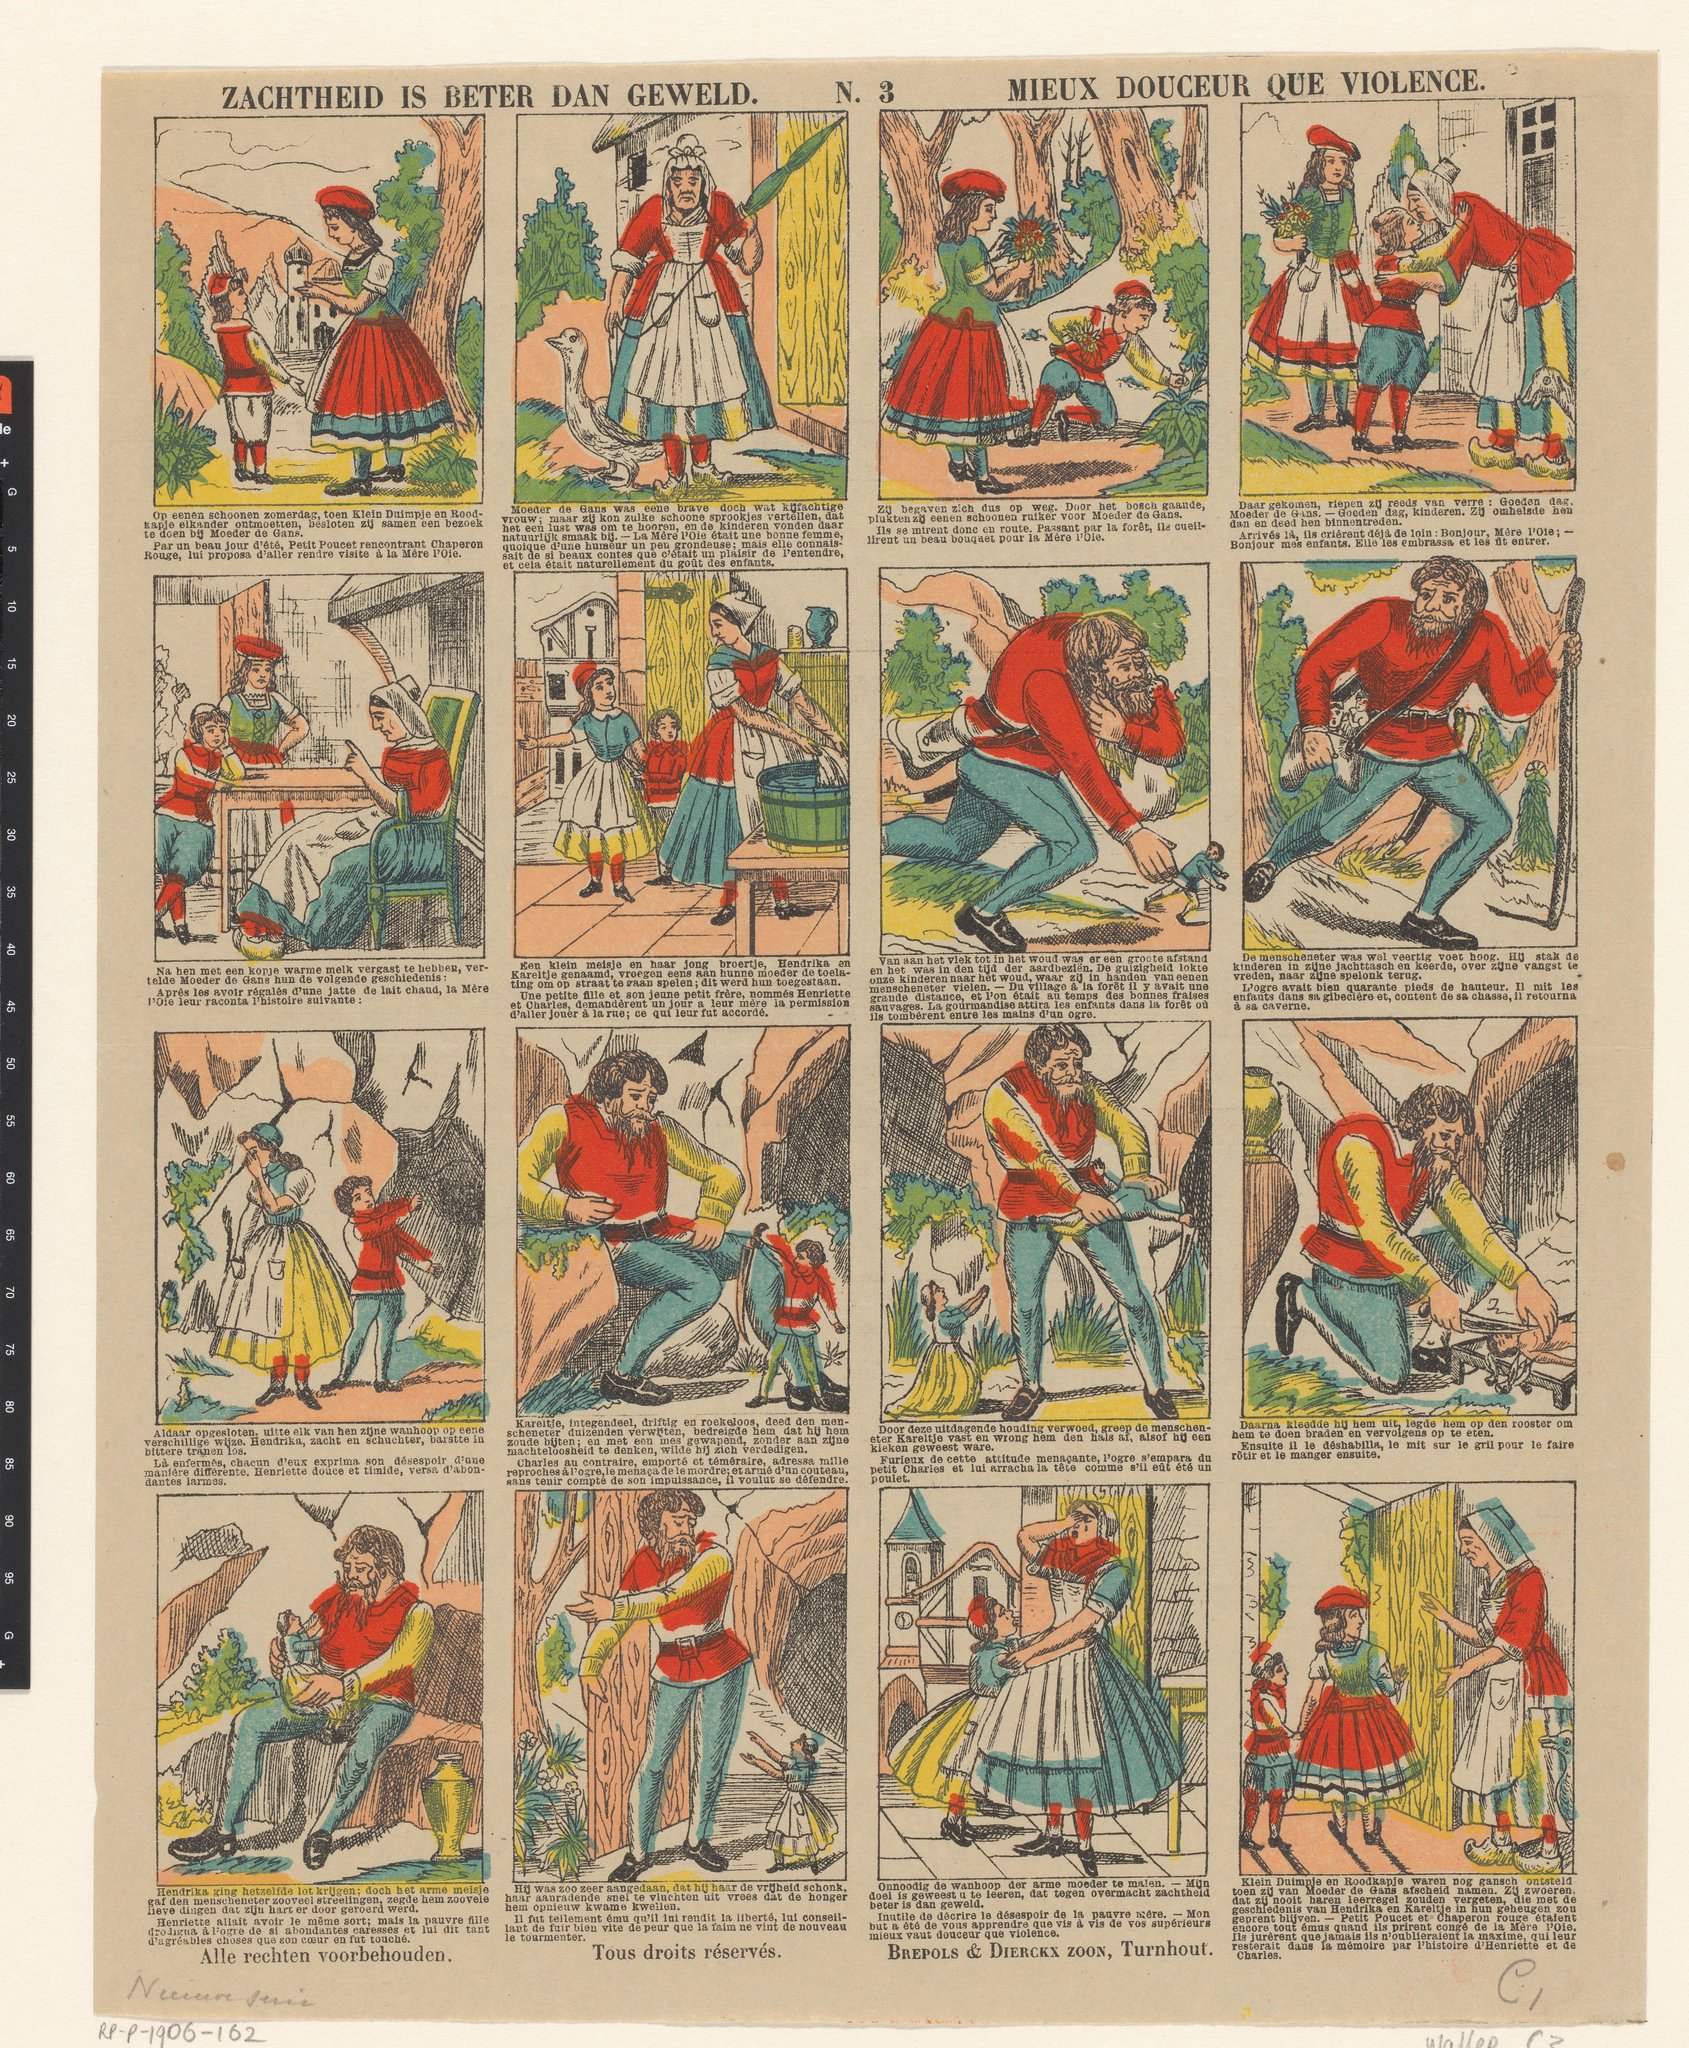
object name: popular print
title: Zachtheid is beter dan geweld / Mieux douceur que violence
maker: Anonymous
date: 1833-1906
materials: paper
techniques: lithograph, letterpress printing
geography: turnhout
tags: tales and fairy tales, tales and fairy tales: little red riding-hood, cannibalism, tales and fairy tales: little thumbling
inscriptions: octrooivermelding, gedrukt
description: Blad met 16 voorstellingen over Moeder Gans die Roodkapje en Klein Duimpje een verhaal over een mensenetende reus verteld. Onder elke afbeelding een onderschrift in het Nederlands en in het Frans. Genummerd midden boven: N. 3.